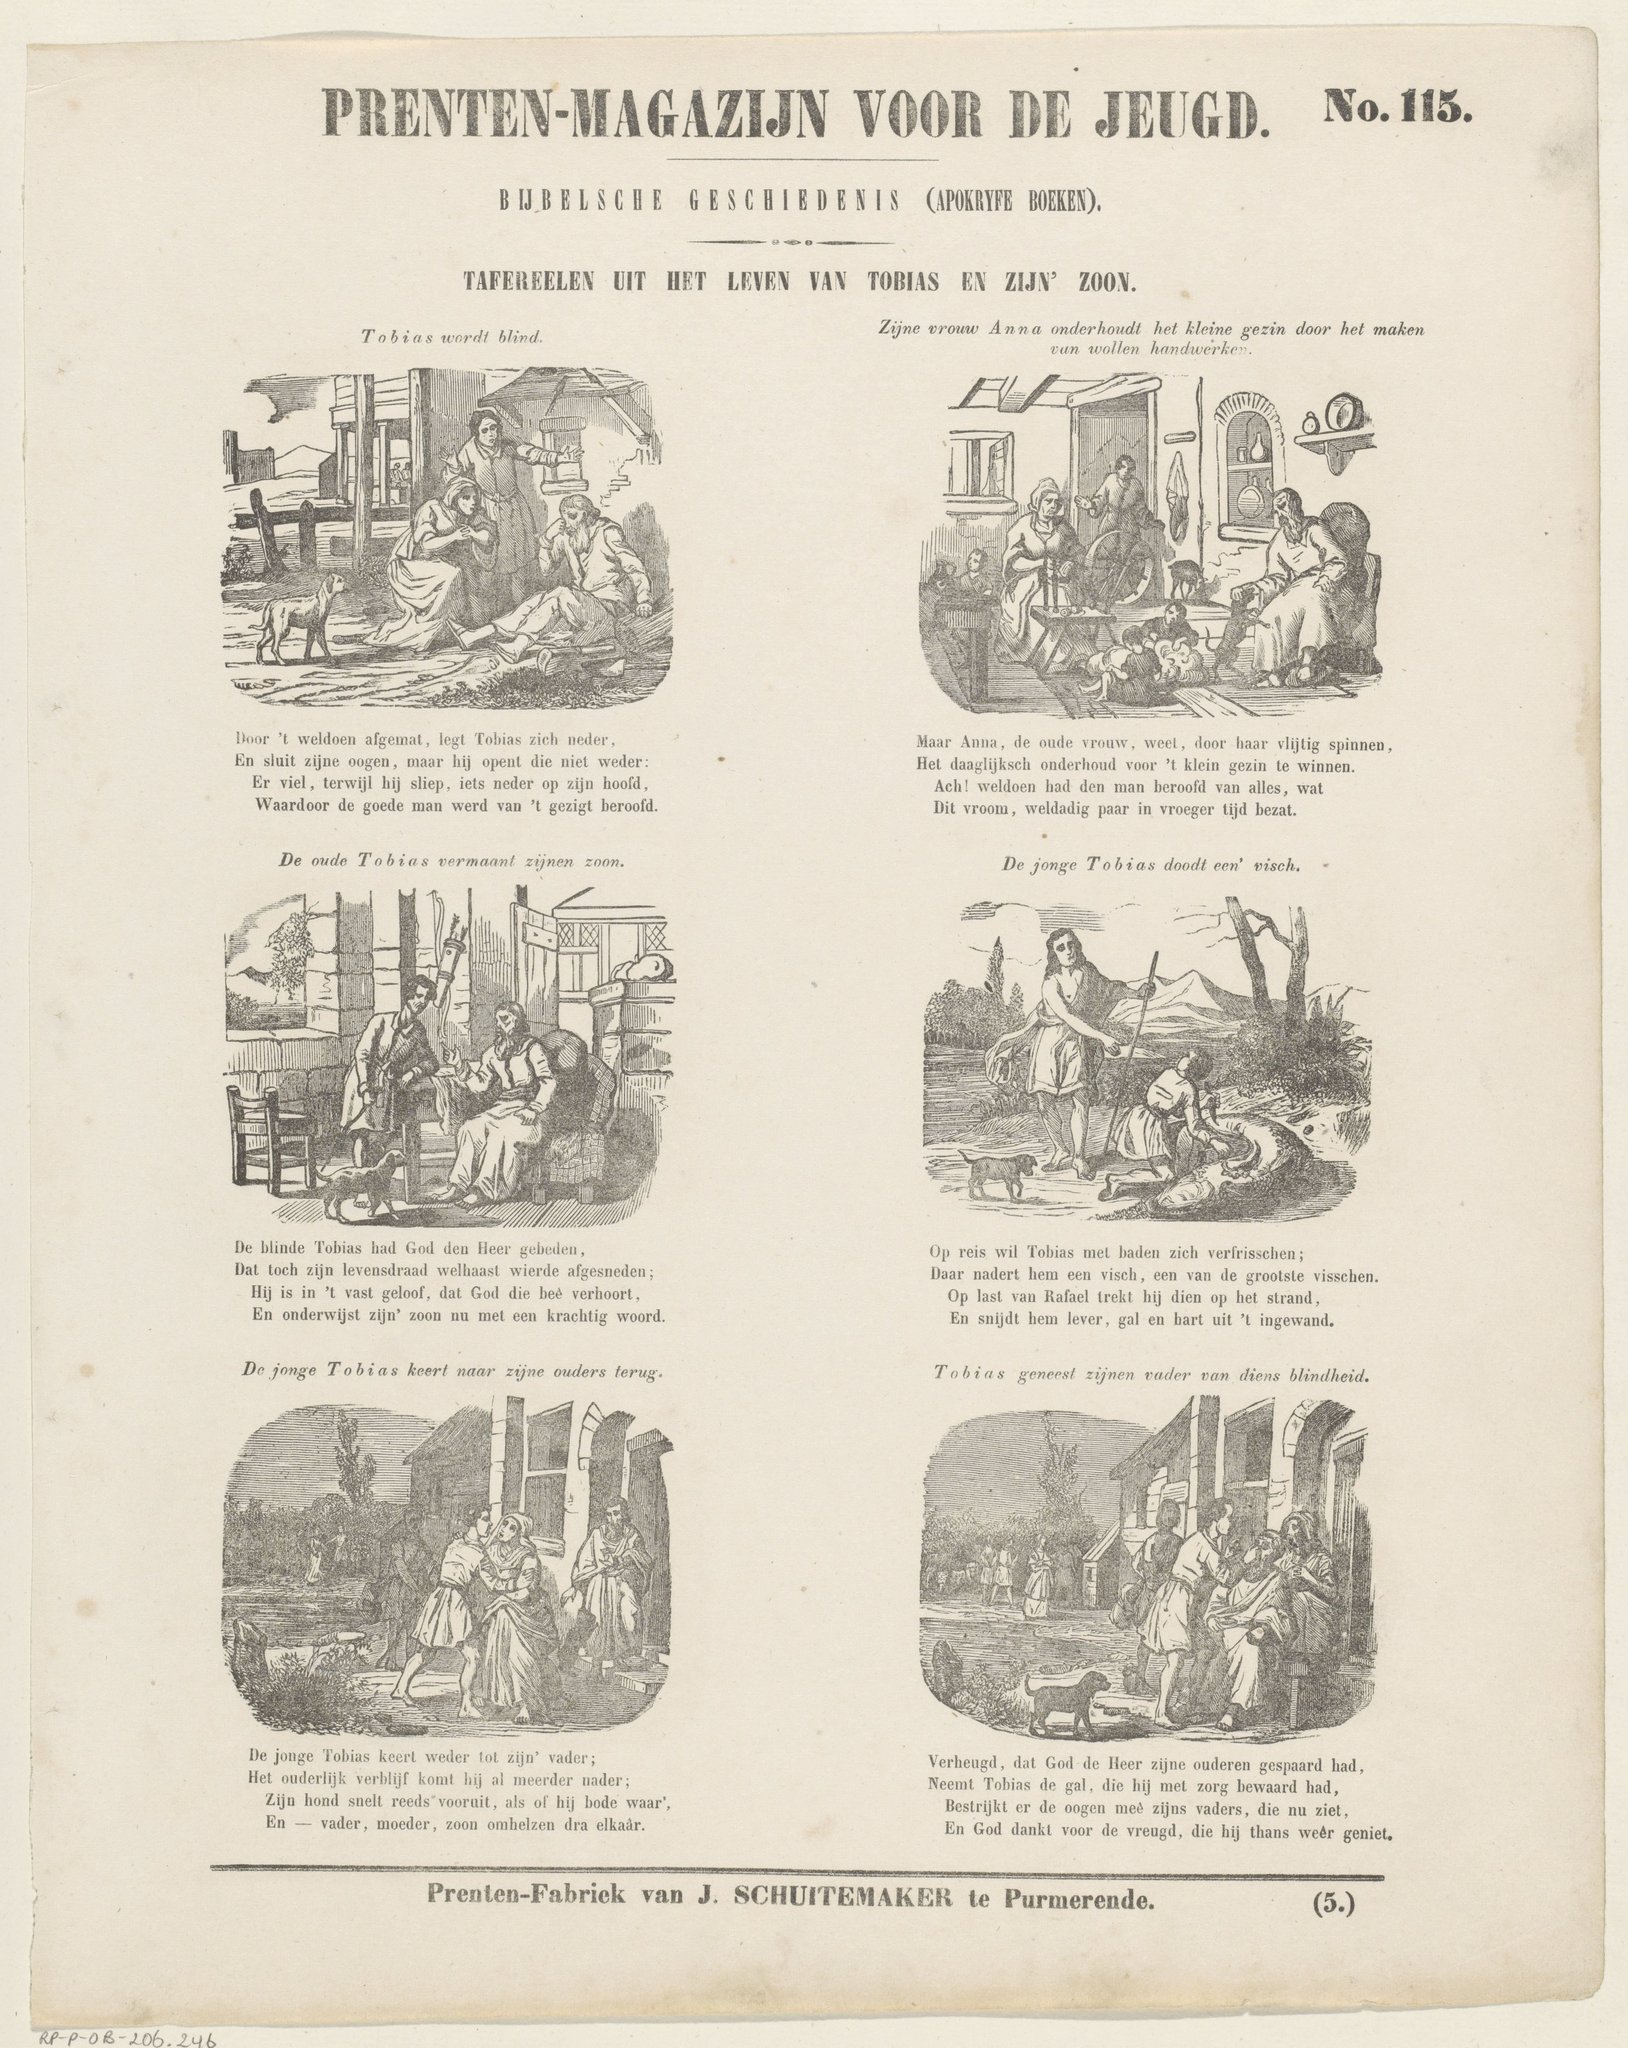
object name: popular print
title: Tafereelen uit het leven van Tobias en zijn' zoon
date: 1850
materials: paper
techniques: letterpress printing, engraving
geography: purmerend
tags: story of tobias: tobias' return (tobit 10-13), old testament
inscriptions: collector's mark: Lugt 2760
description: Na voltooiing van de acht jaargangen van de reeks 'Prenten-magazijn voor de jeugd' in 1850 heeft Jan Schuitemaker al deze prenten heruitgegeven en omgenummerd als nr. 1 t/m 192. De oorspronkelijke jaargang wordt telkens nog vermeld rechtsonder op de prent. Binnen de jaargangen zijn prenten van hetzelfde thema in clusters van vier achter elkaar gezet.